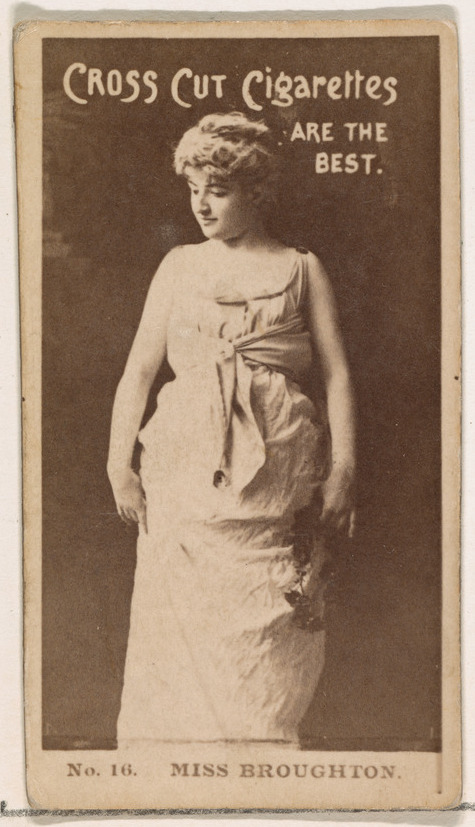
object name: print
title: Card Number 16, Miss Broughton, from the Actors and Actresses series (N145-2) issued by Duke Sons & Co. to promote Cross Cut Cigarettes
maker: w. duke, sons & co.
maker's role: publisher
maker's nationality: american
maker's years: 1870-1920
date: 1880-1889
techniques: albumen silver print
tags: portraits,women,actresses